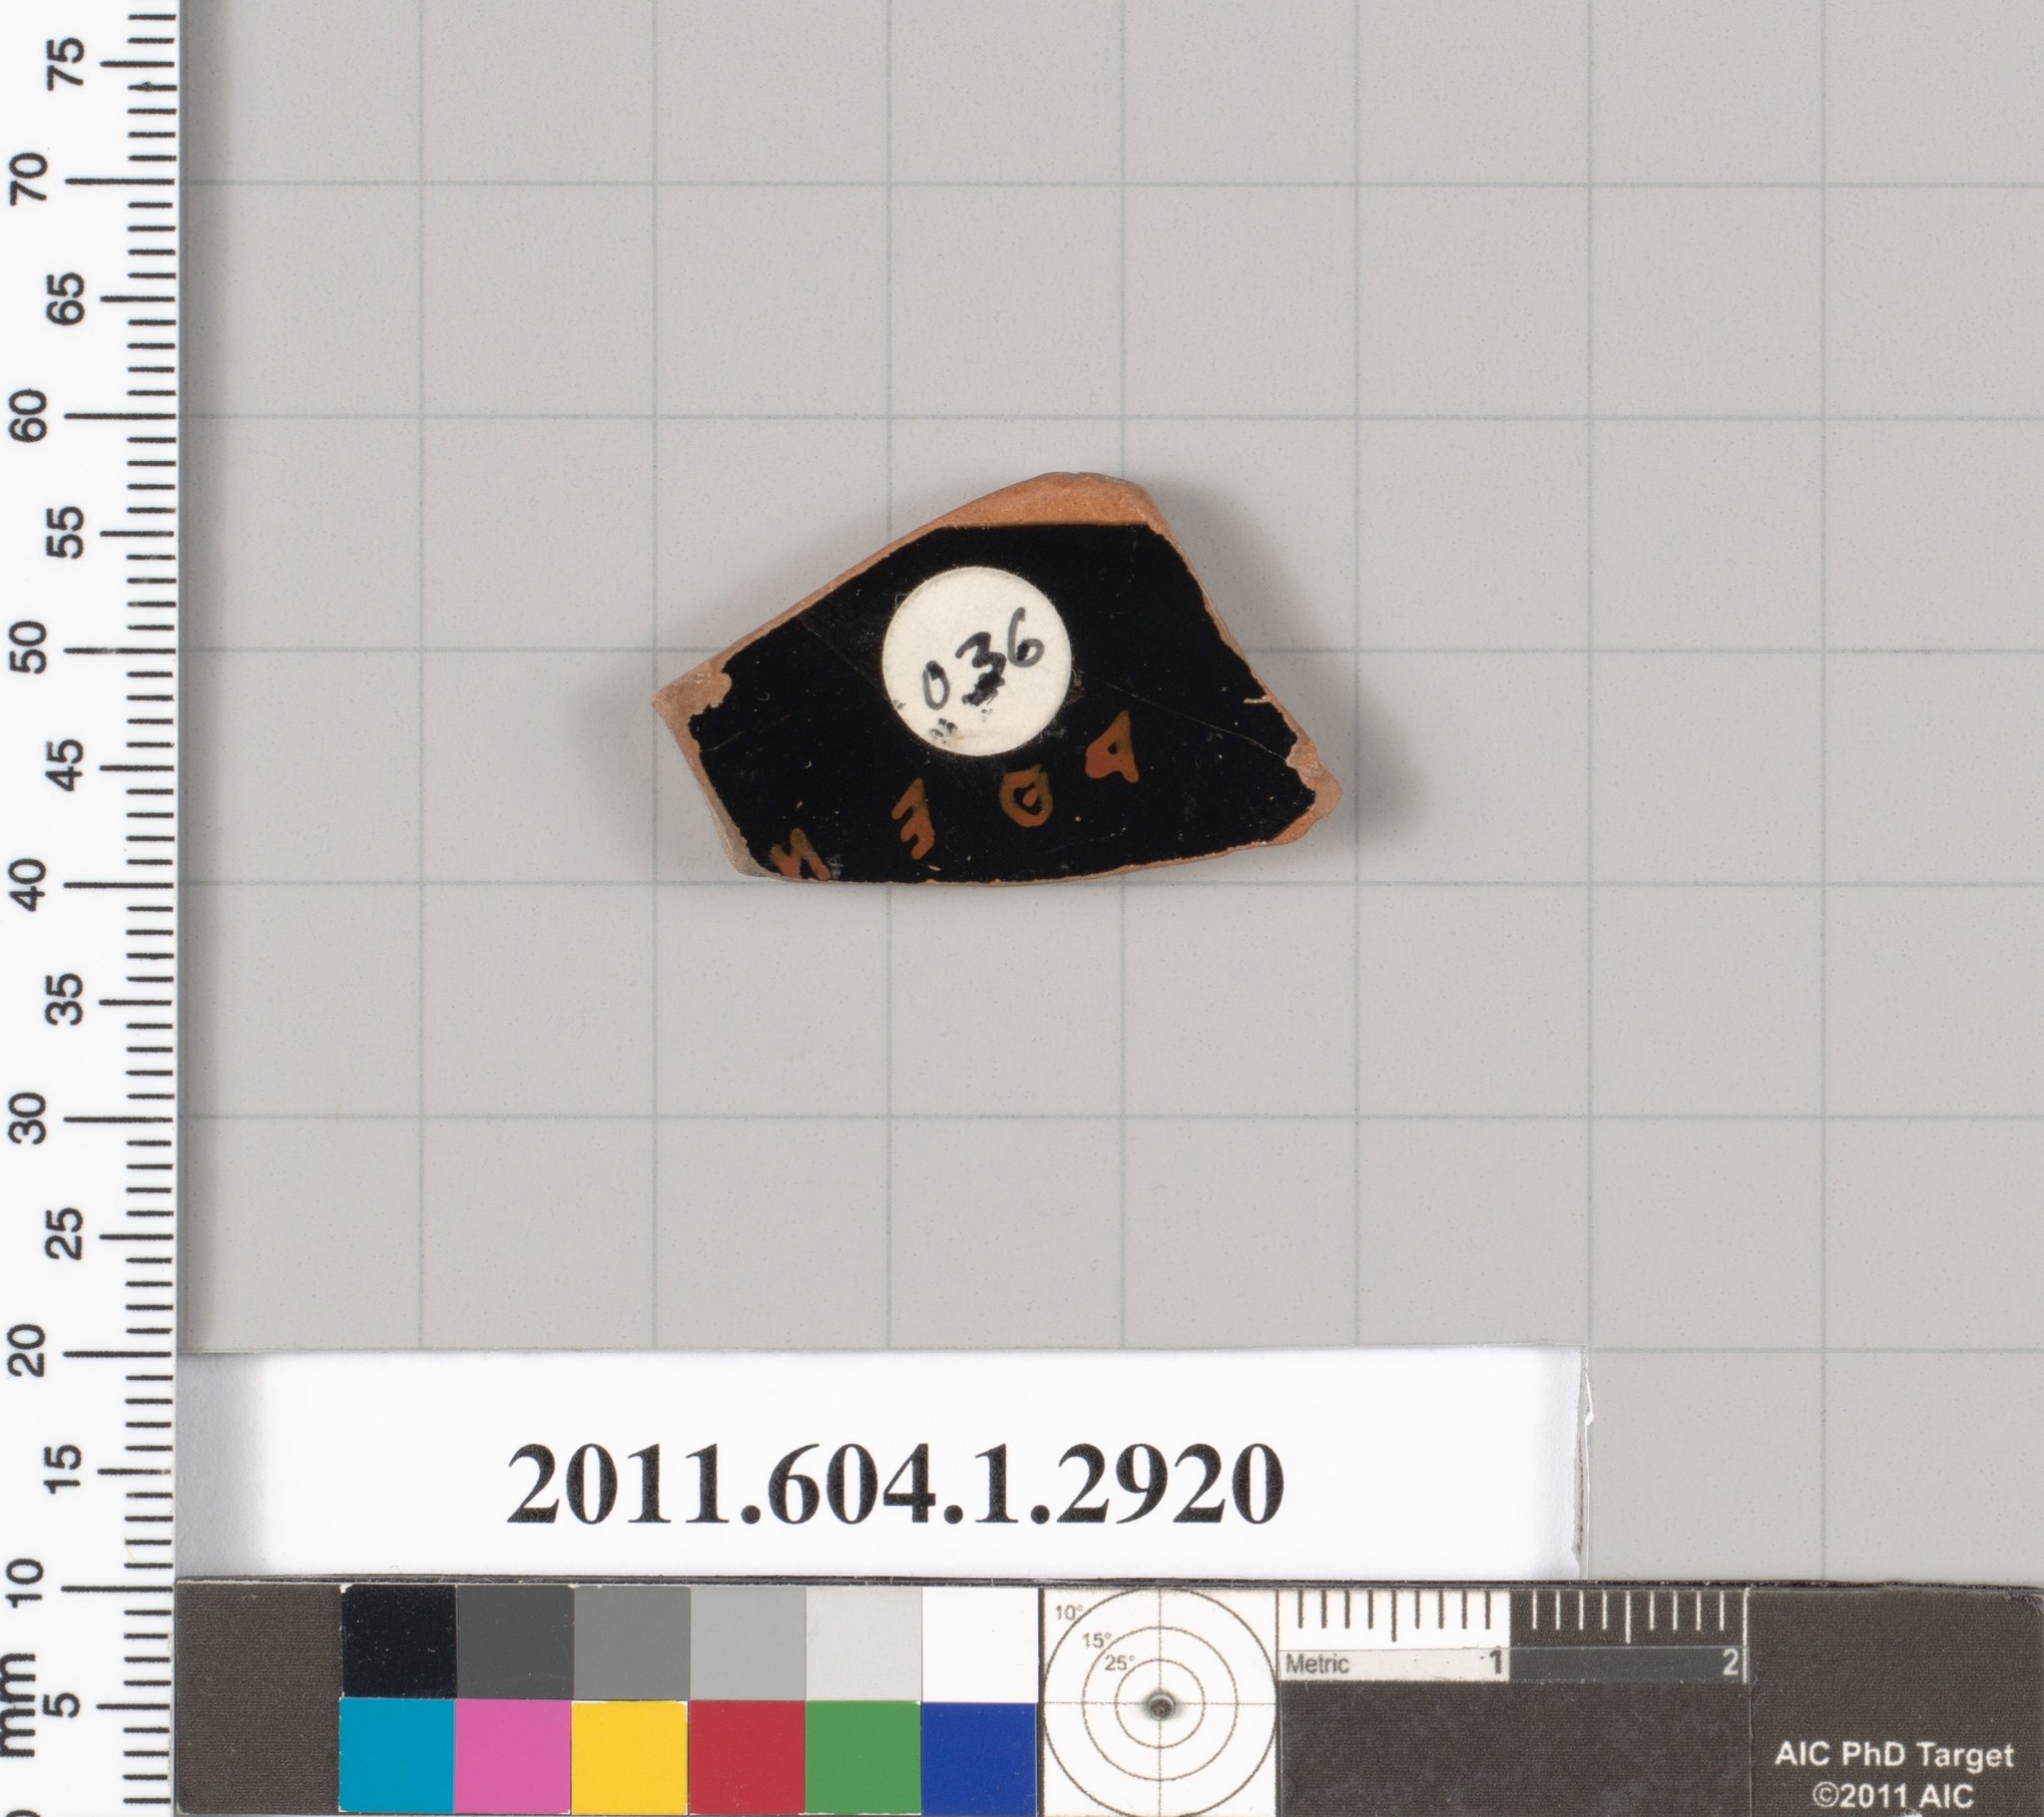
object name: kylix fragment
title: Terracotta fragment of a kylix (drinking cup)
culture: greek, attic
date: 600-401 BCE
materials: terracotta